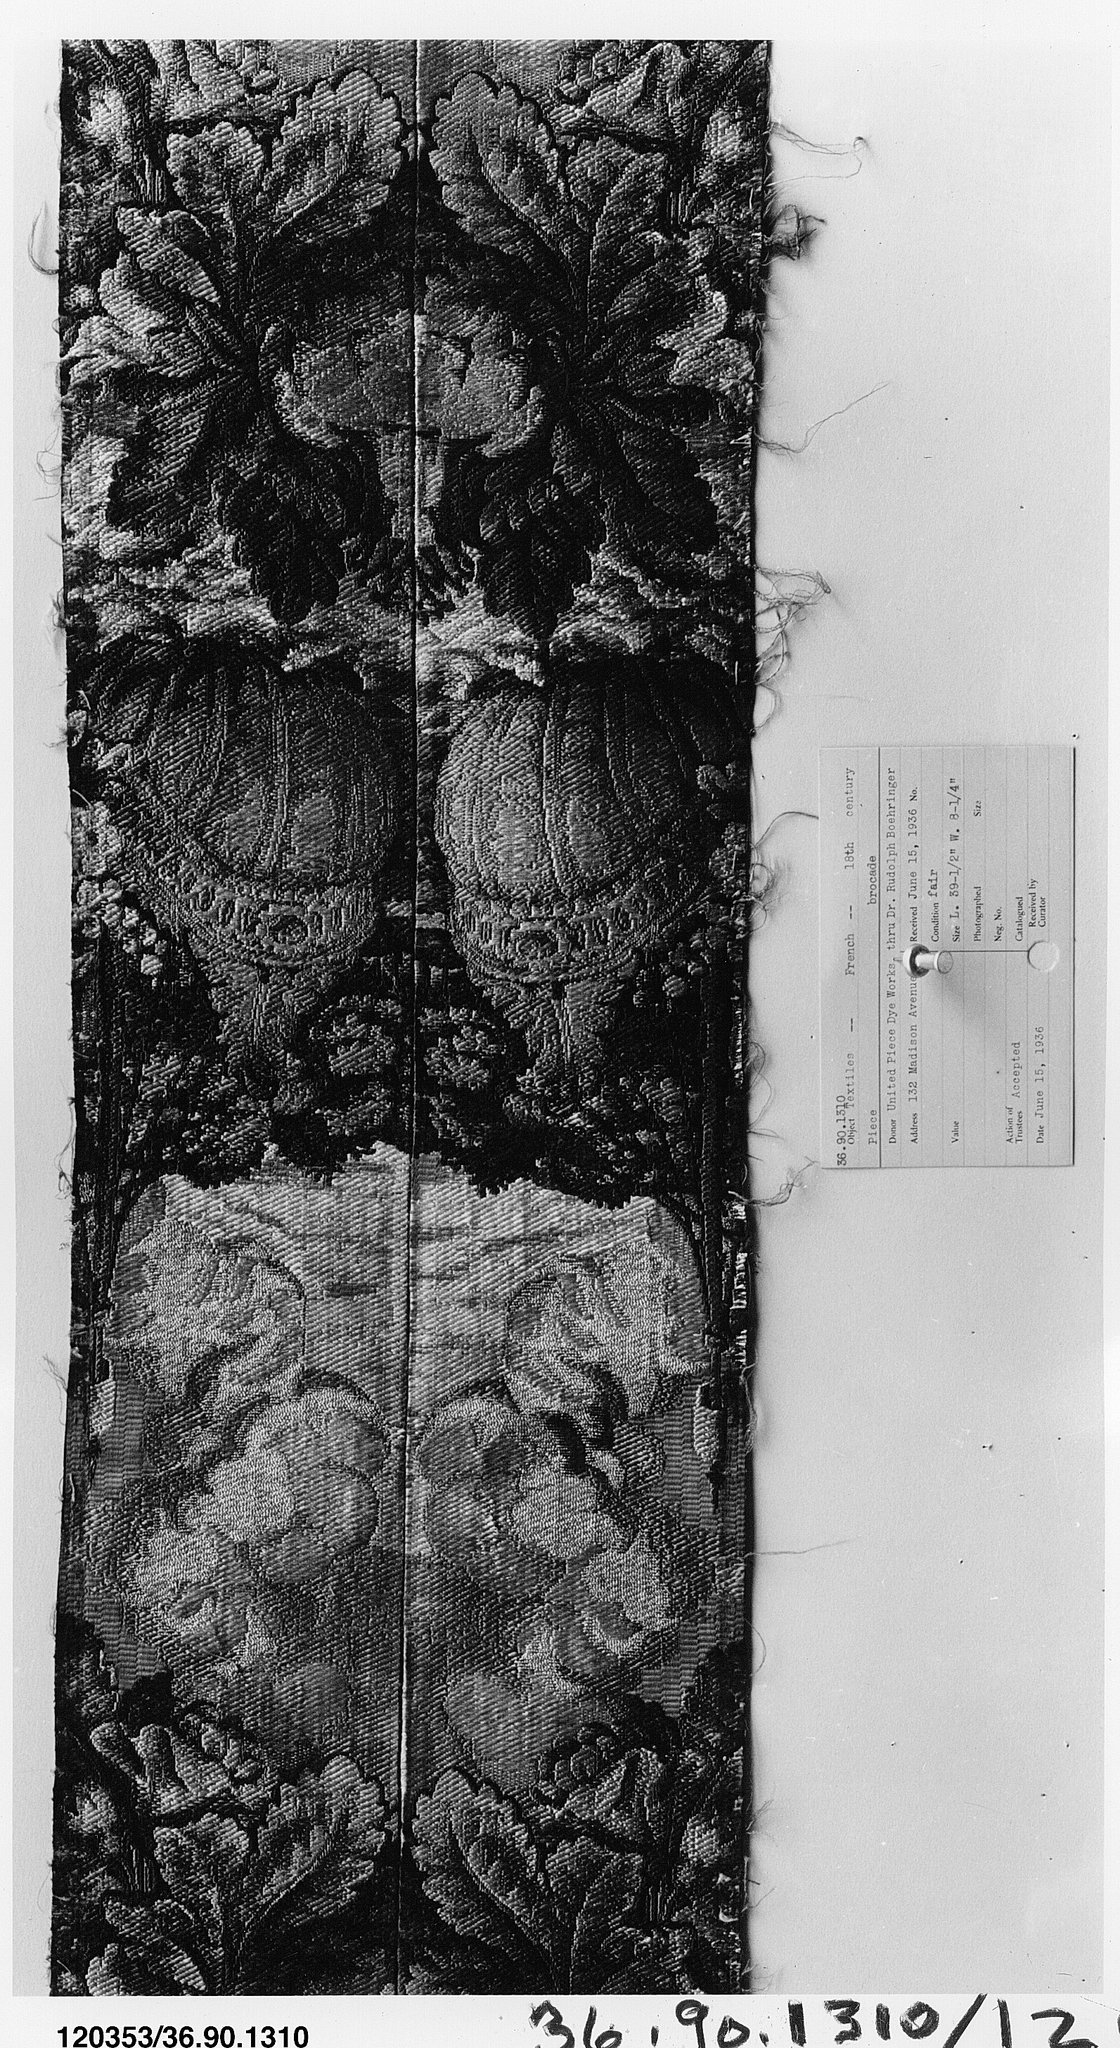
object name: piece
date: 1735-1740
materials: metal thread, silk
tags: leaves